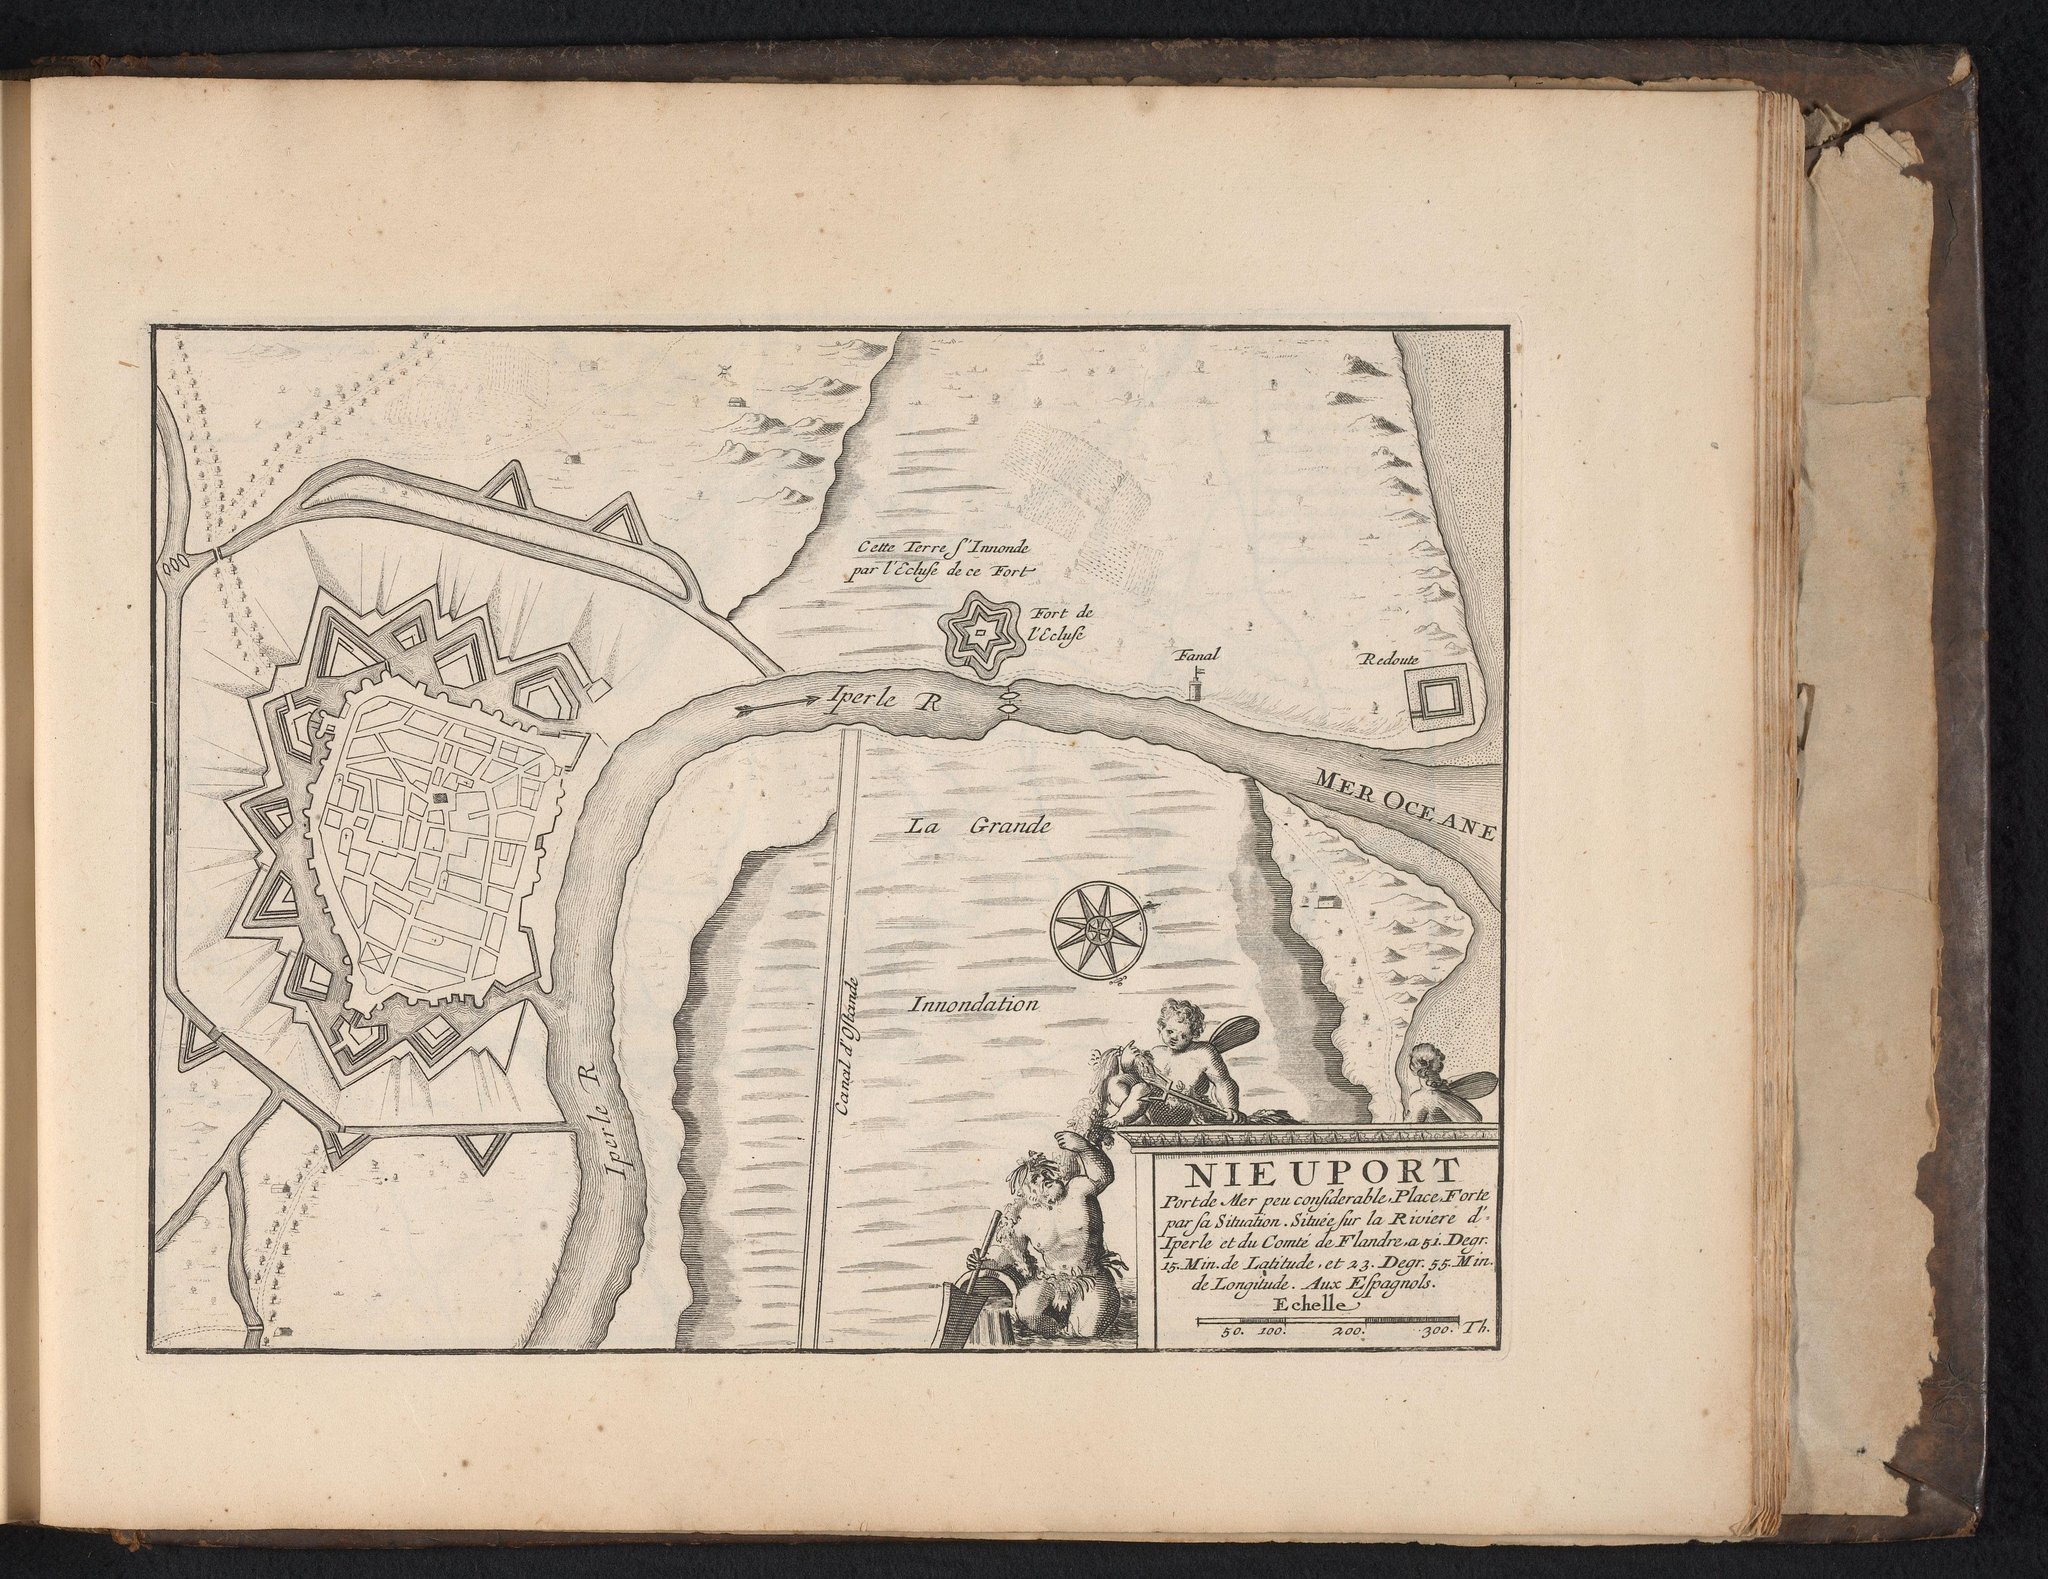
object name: map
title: Le theatre de la guerre, dans les Pays-Bas, ou representation des principales villes qui sont en Flandre, Hainaut, Brabant, et c. : avec leurs fortifications : dessignées par les meilleurs ingenieurs, particulierement celles (...) dont les plans ont esté levez par M. de Vauban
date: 1693-1696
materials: paper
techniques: engraving, etching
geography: paris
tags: fortress, maps of cities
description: Plattegrond van de versterkingen om de Vlaamse stad Nieuwpoort. Onderdeel van het tweede van twee delen van het prentwerk: Le Theatre de la Guerre, dans les Pays-Bas, waarvan het titelblad uitgegeven is in 1696. Het prentwerk bestaat in totaal (beide delen) uit 52 platen met plannen (afkomstig van Sébastien Le Prestre, Seigneur de Vauban) van vermaarde sterke steden en vestingen in de Negenjarige Oorlog in de Nederlanden. Latere opgewerkte staat van dezelfde plaat die voorkomt in: Les forces de l'Europe, uitgegeven tussen 1693-1697. Titel en opschriften in het Frans.